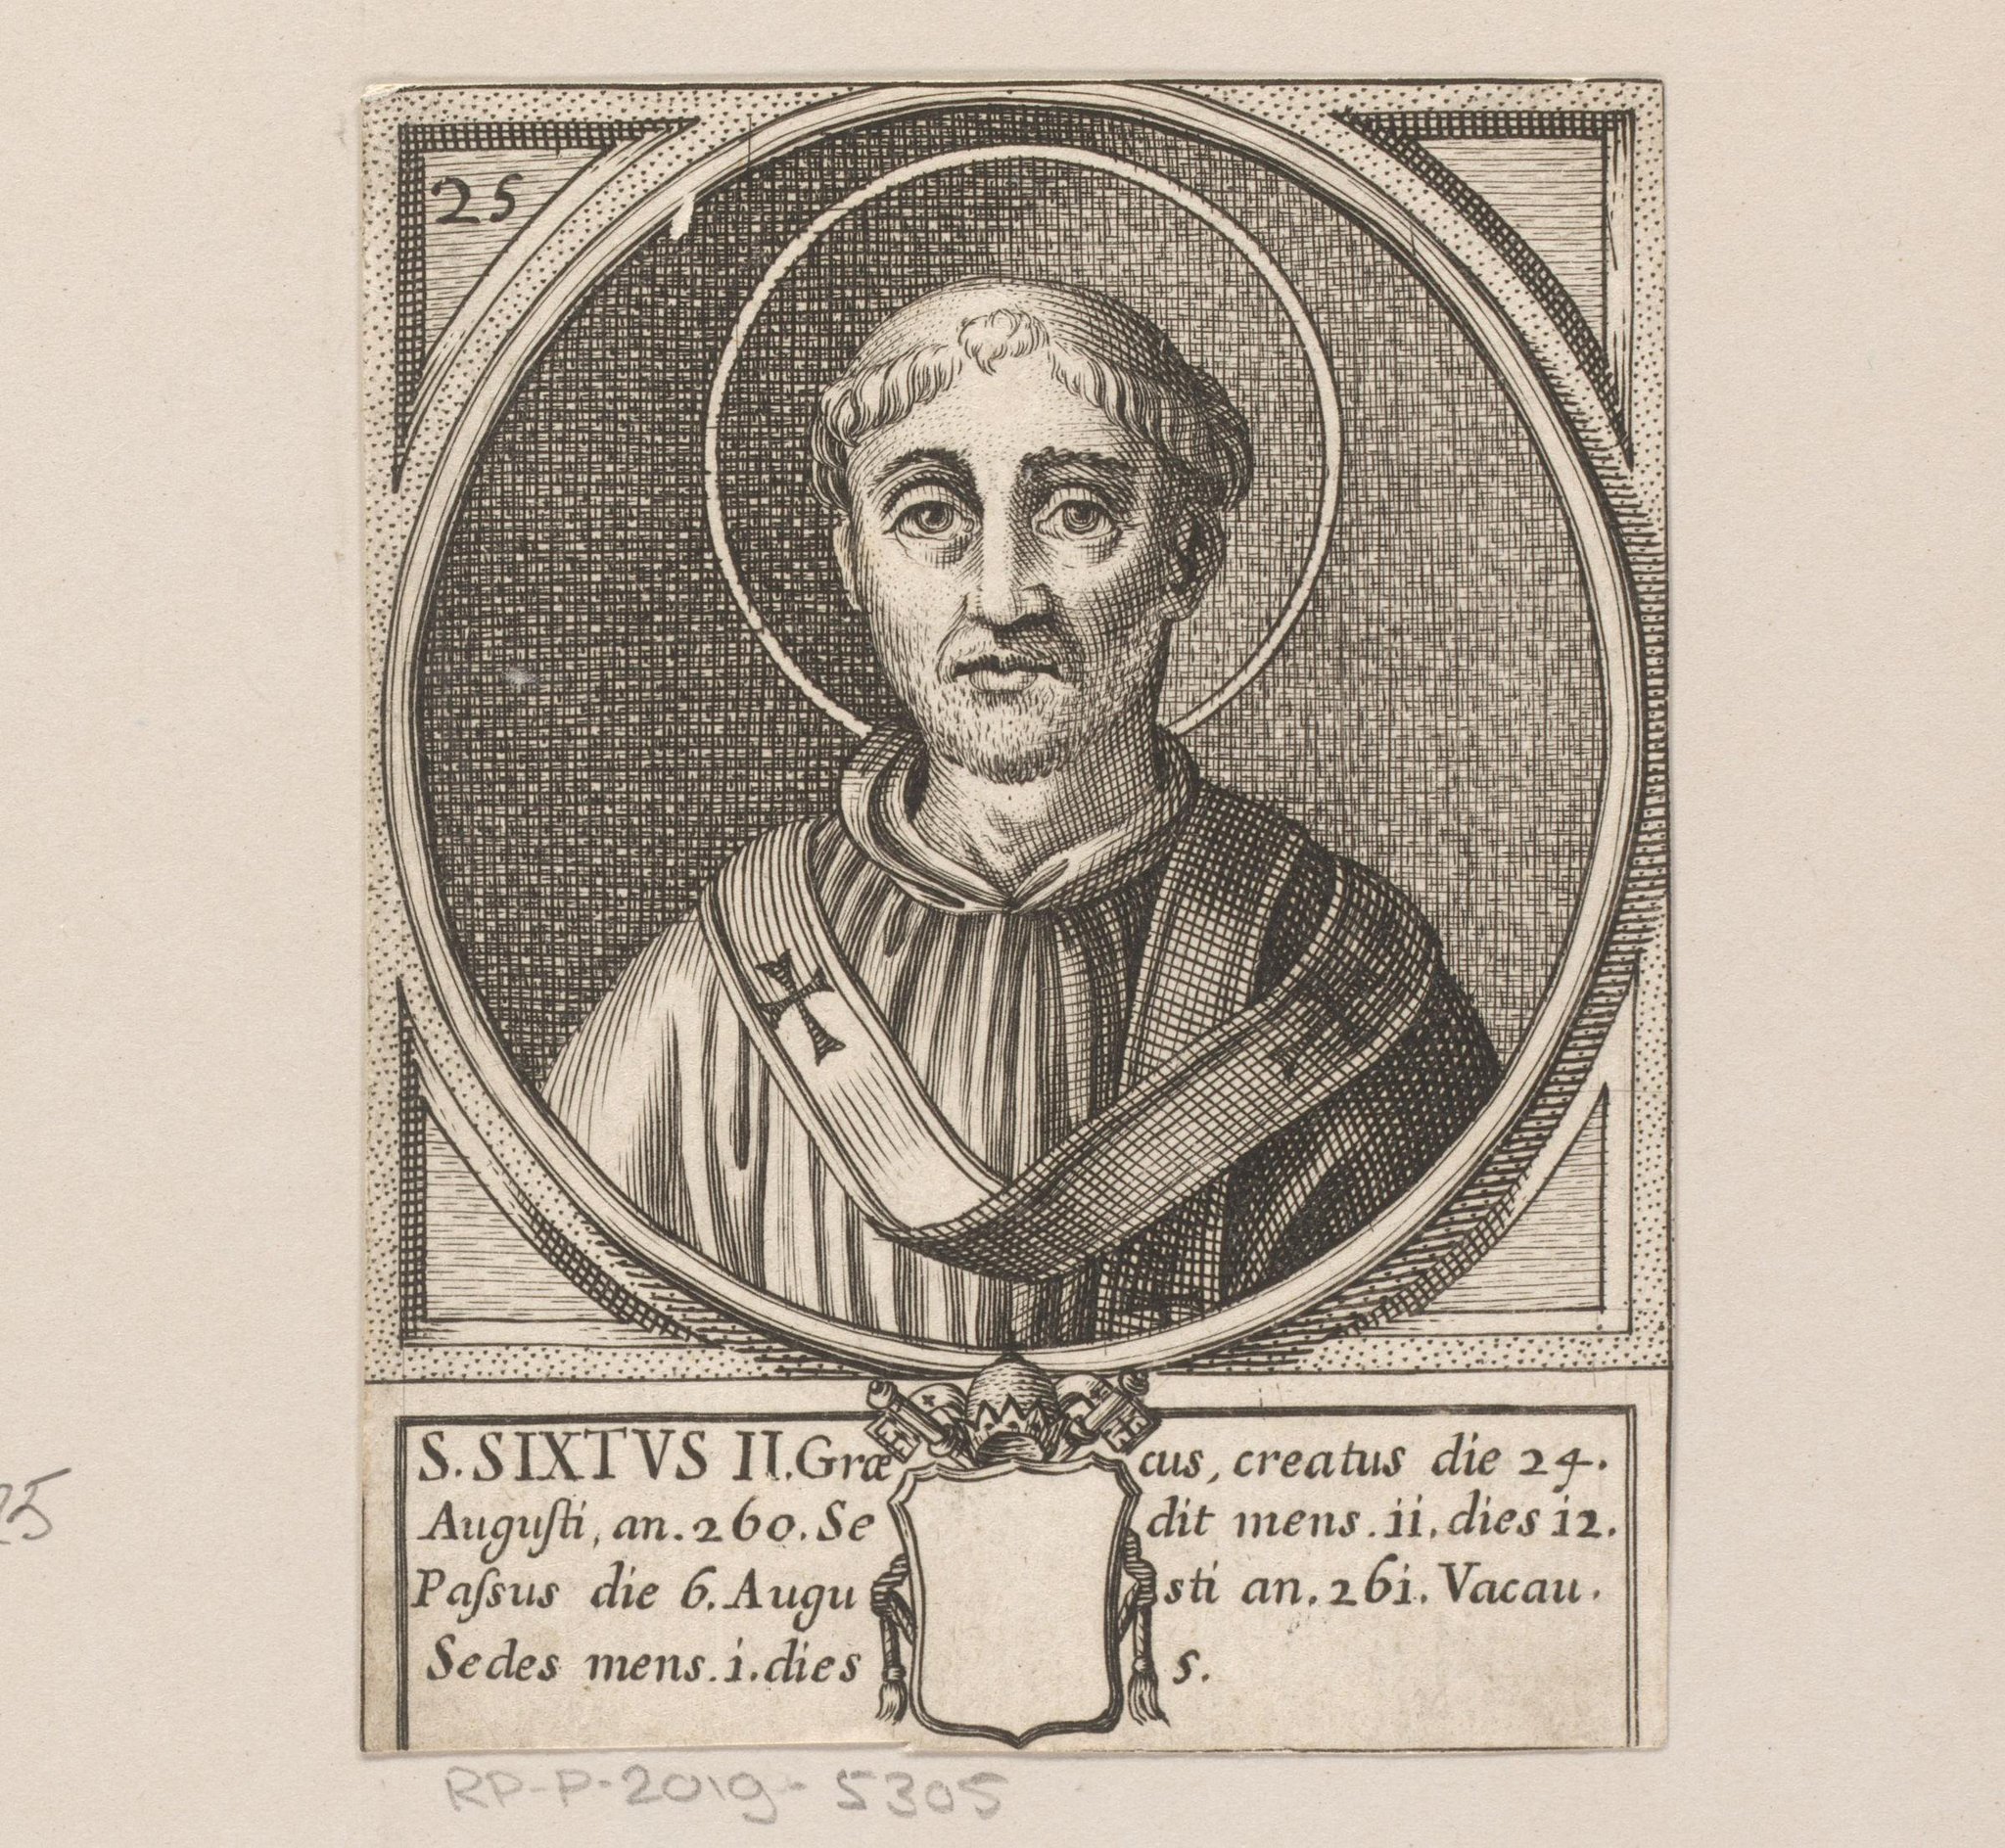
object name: print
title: Chronologia Summorum Romanorum Pontificum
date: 1675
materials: paper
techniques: engraving, etching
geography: rome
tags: rome, historical persons, pope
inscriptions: inscription: ‘N148617 3’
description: Portret afkomstig uit een grote prent, bestaande uit 17 bladen die samengevoegd konden worden, uitgegeven door Giovanni Giacomo de' Rossi in 1675.